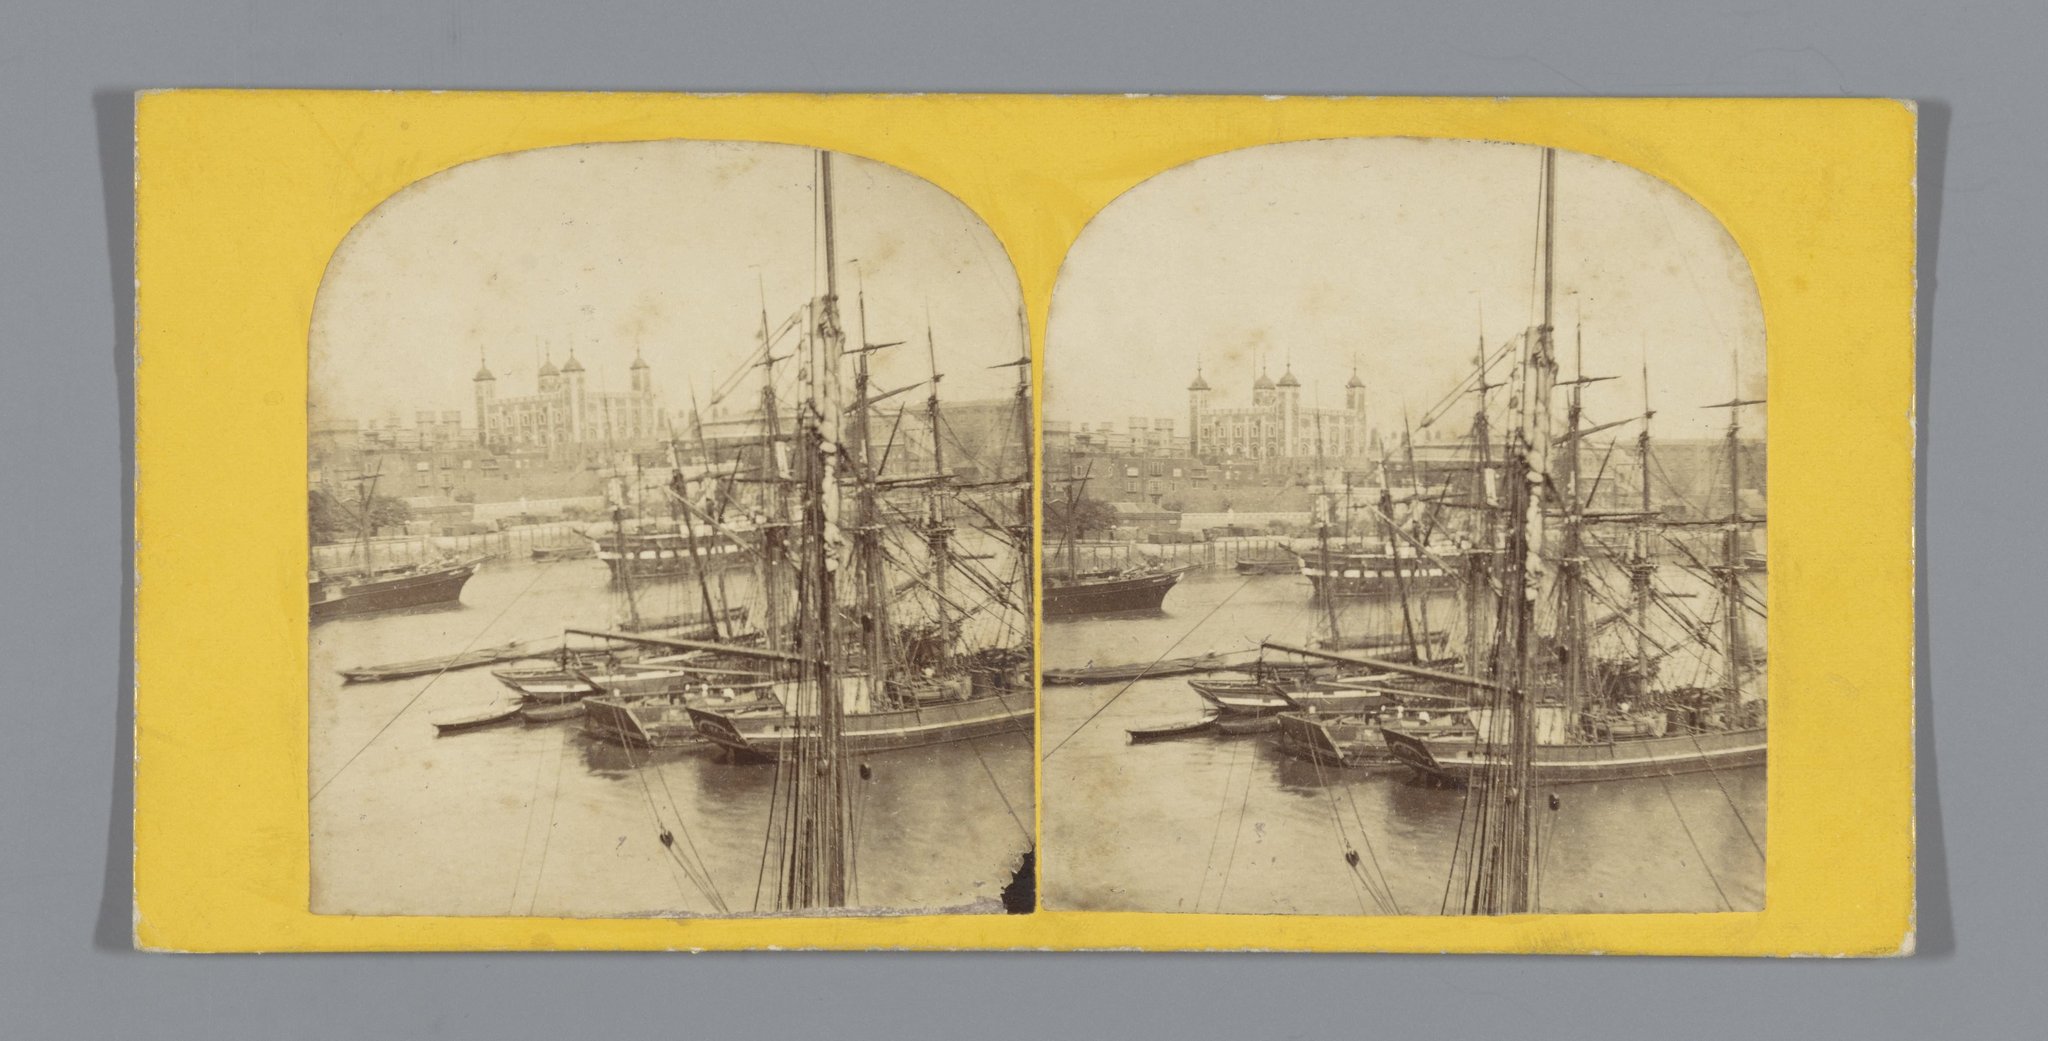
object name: stereograph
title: The Tower, London. Taken from the Thames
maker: Anonymous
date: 1850-1880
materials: cardboard, photographic support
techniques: albumen print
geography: london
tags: castle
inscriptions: number: ‘104’, inscription: ‘London Juni 1886 Sept 1891’, inscription: ‘Instantaneous’